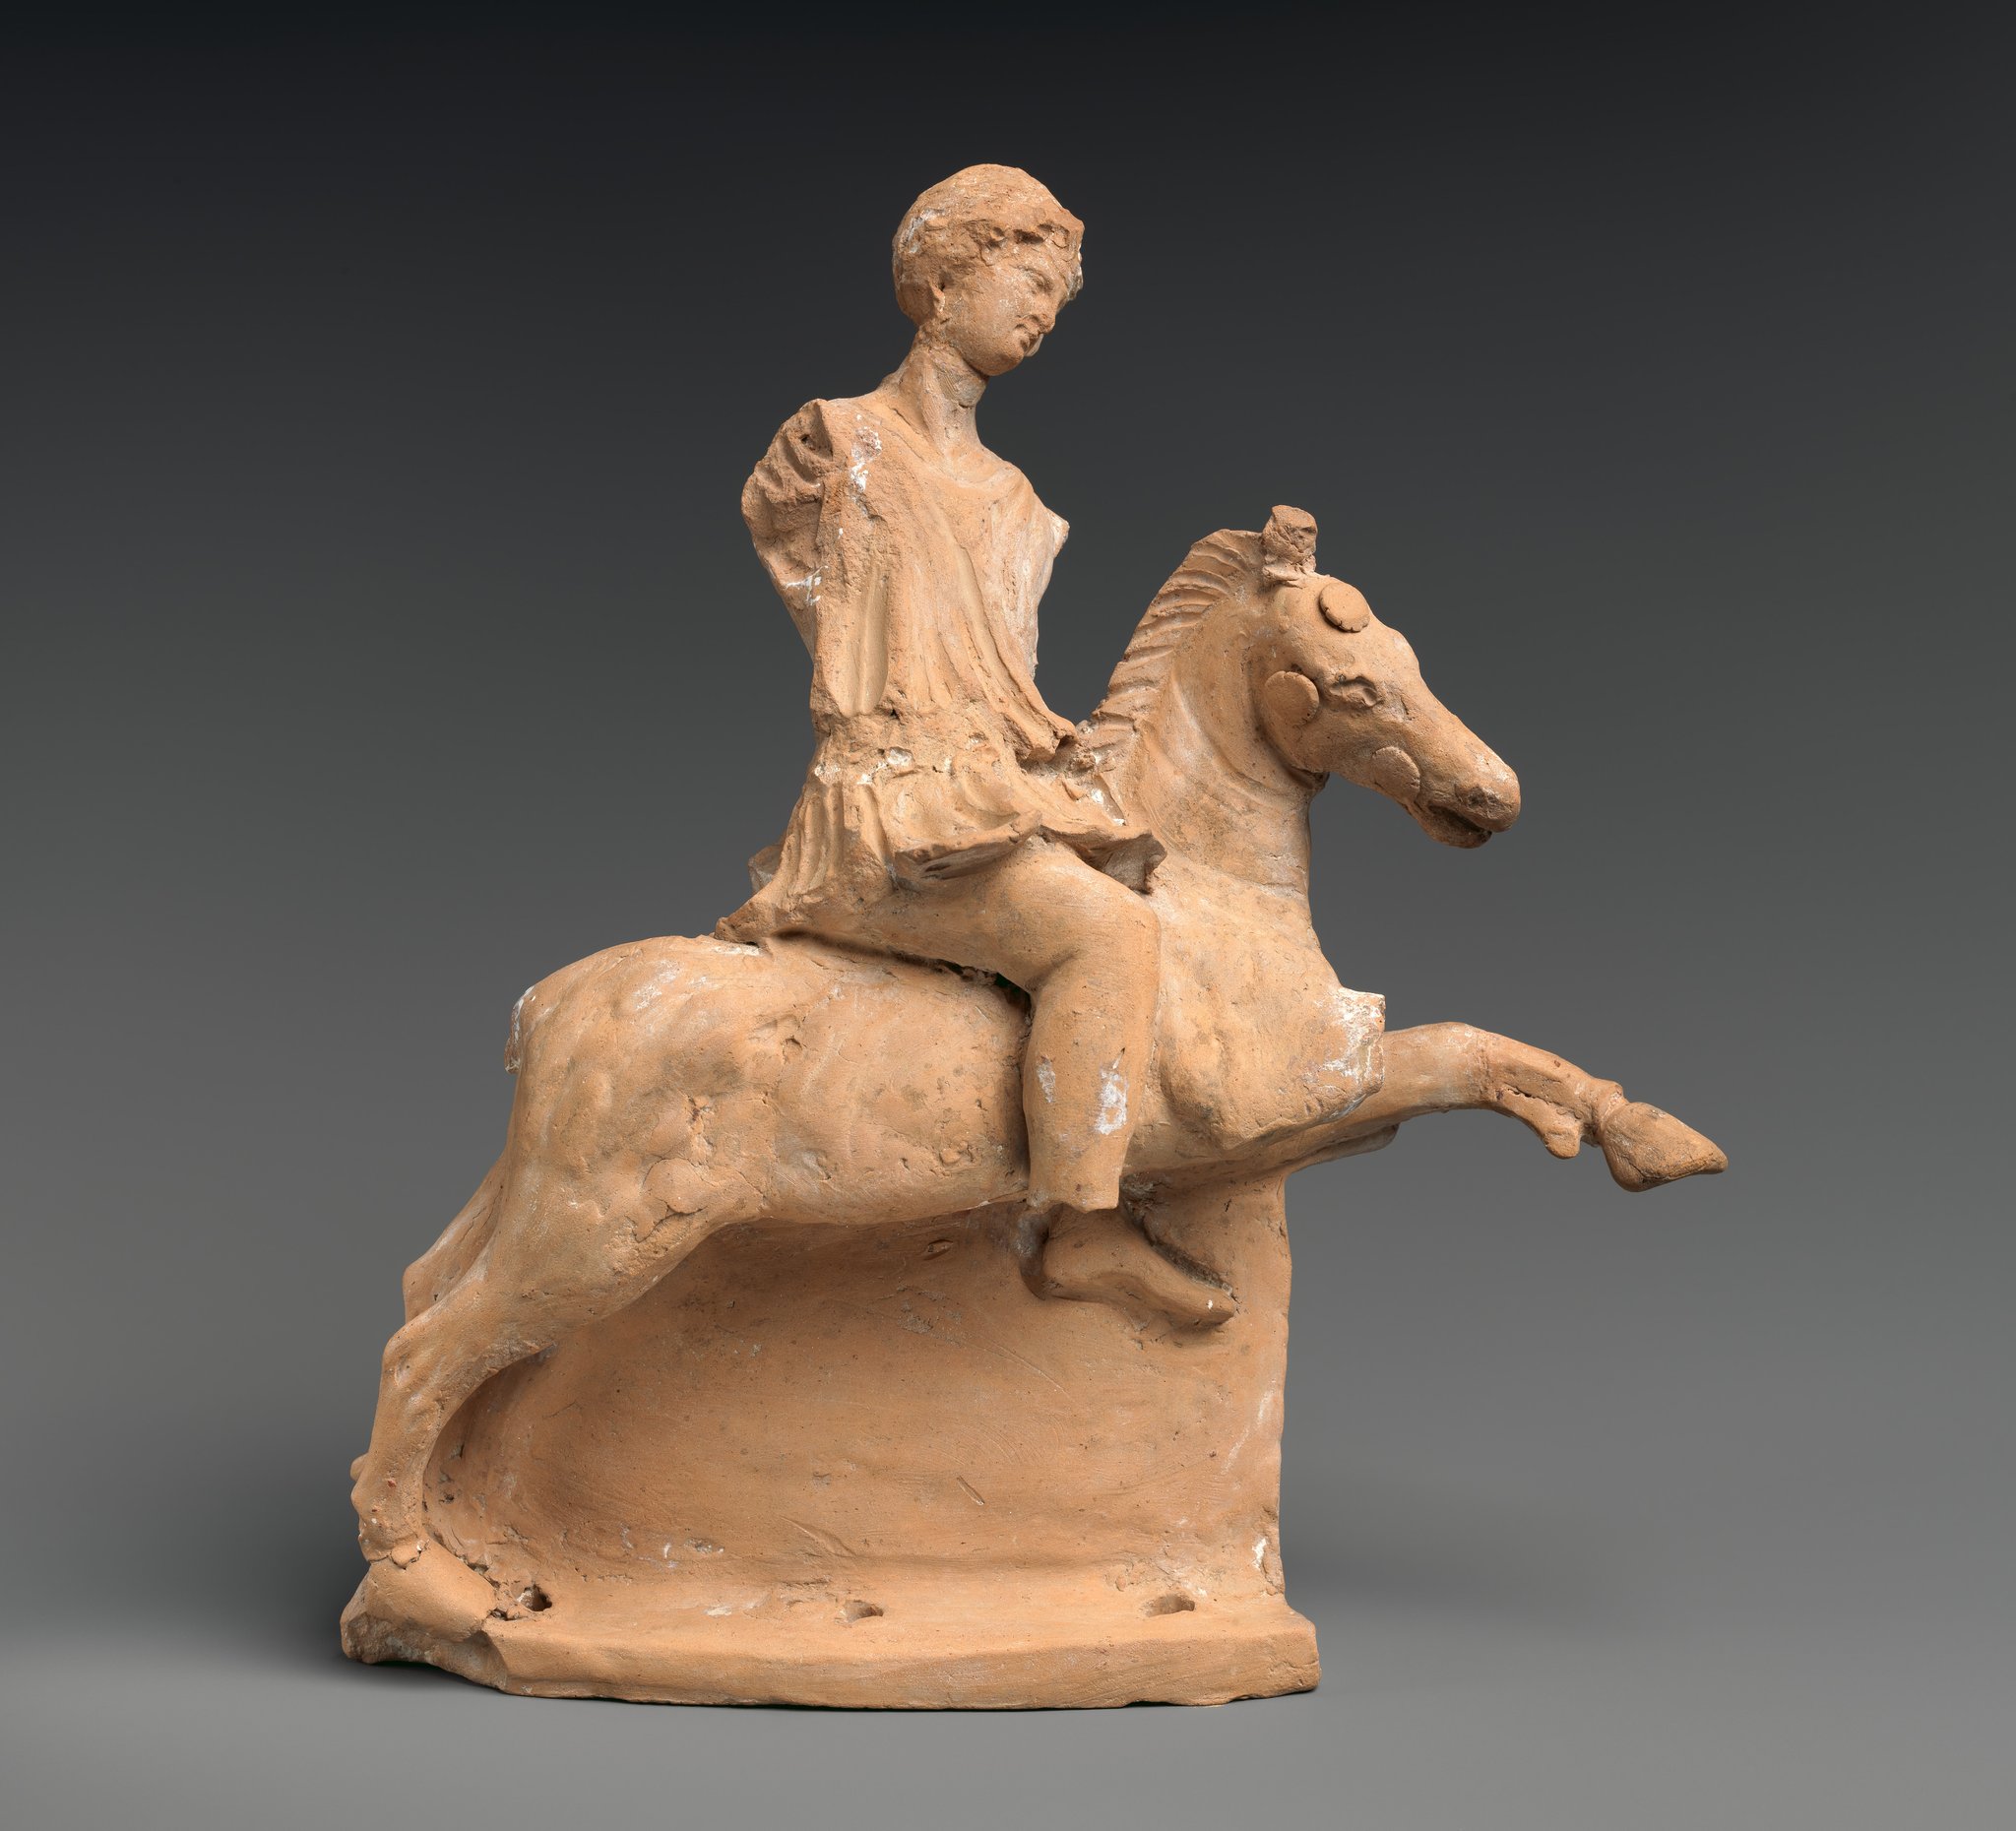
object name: relief from funnel jar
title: Terracotta relief detached from a funnel-jar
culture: canosan or south italian or italic-native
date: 334-268 BCE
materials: terracotta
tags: horses